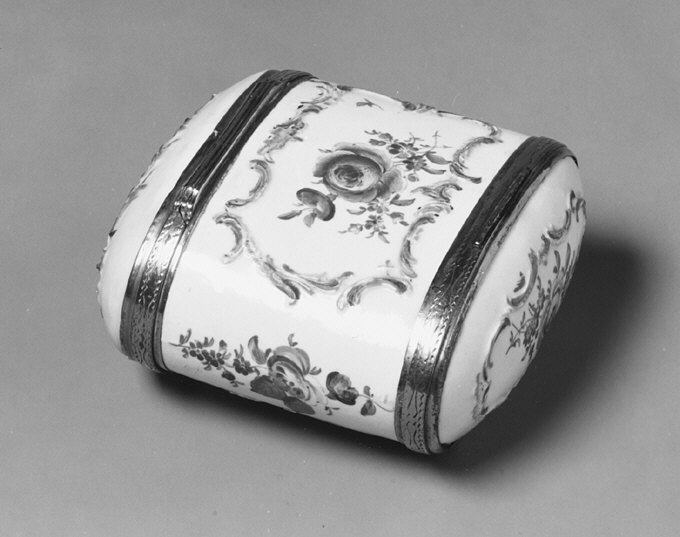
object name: double snuffbox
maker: nymphenburg porcelain manufactory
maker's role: manufactory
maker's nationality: german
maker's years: 1747-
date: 1755-1760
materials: hard paste porcelain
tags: flowers